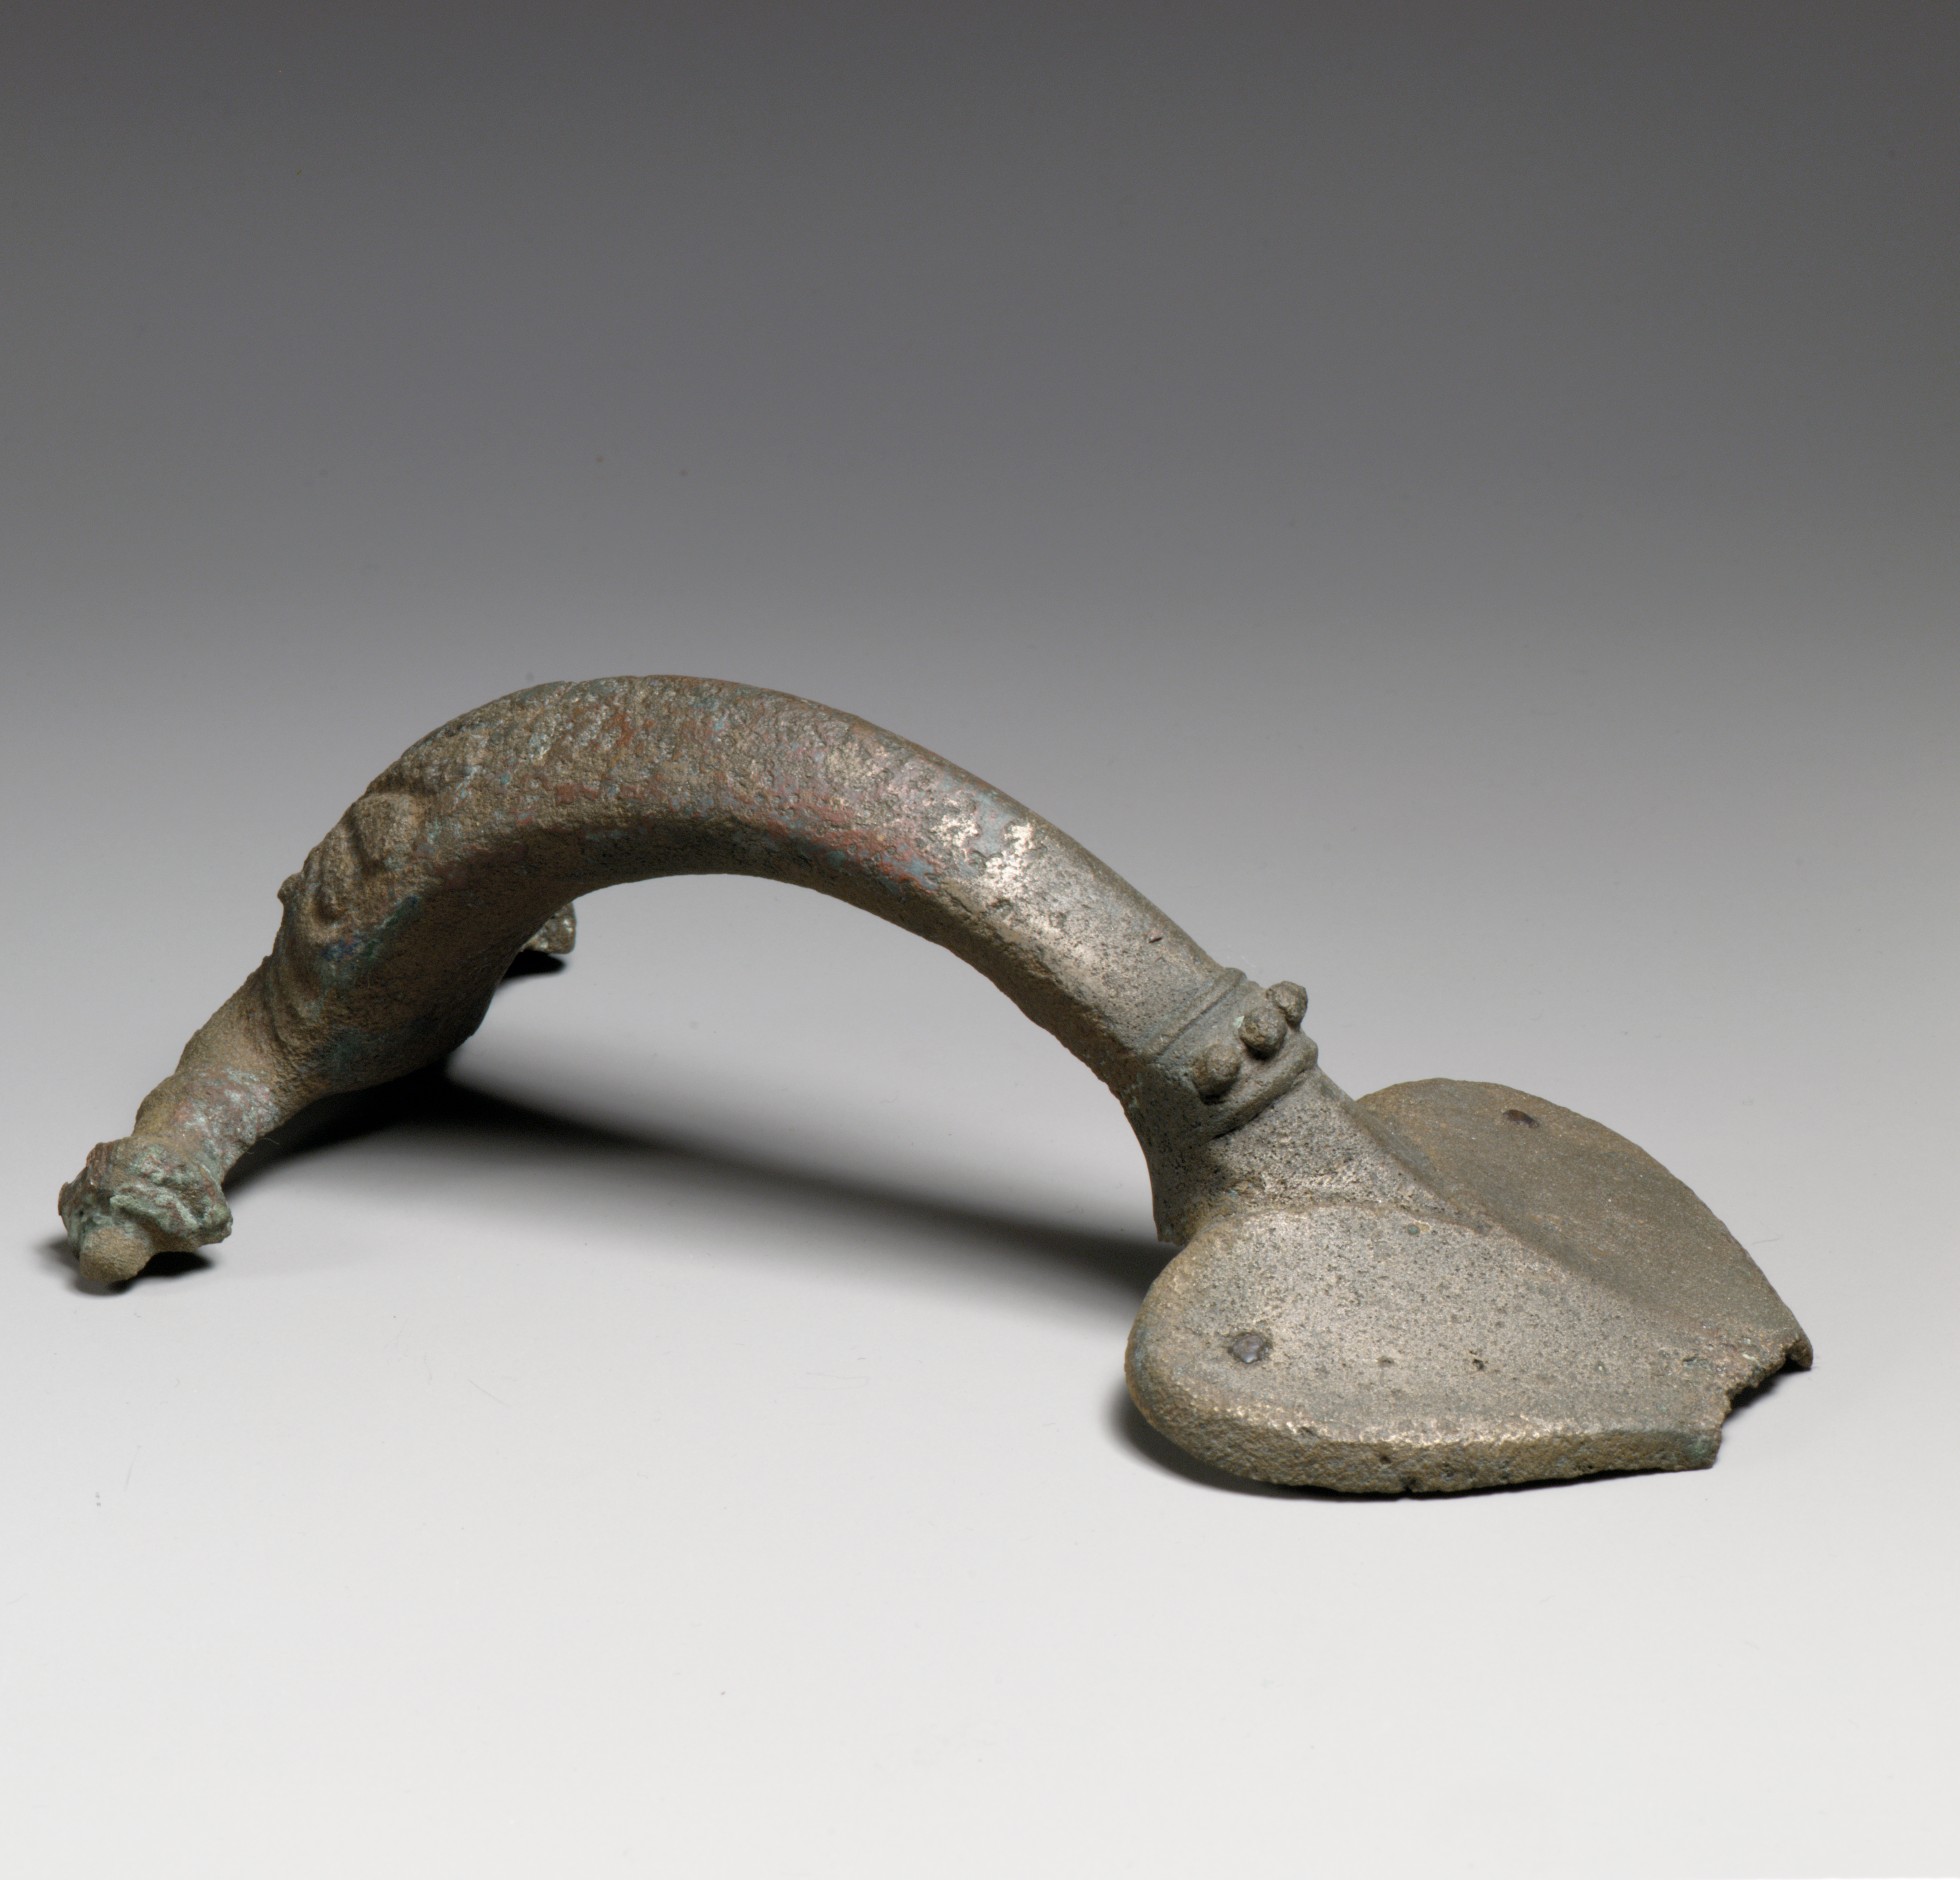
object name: handle of a hydria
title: Bronze handle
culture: greek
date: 434-401 BCE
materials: bronze